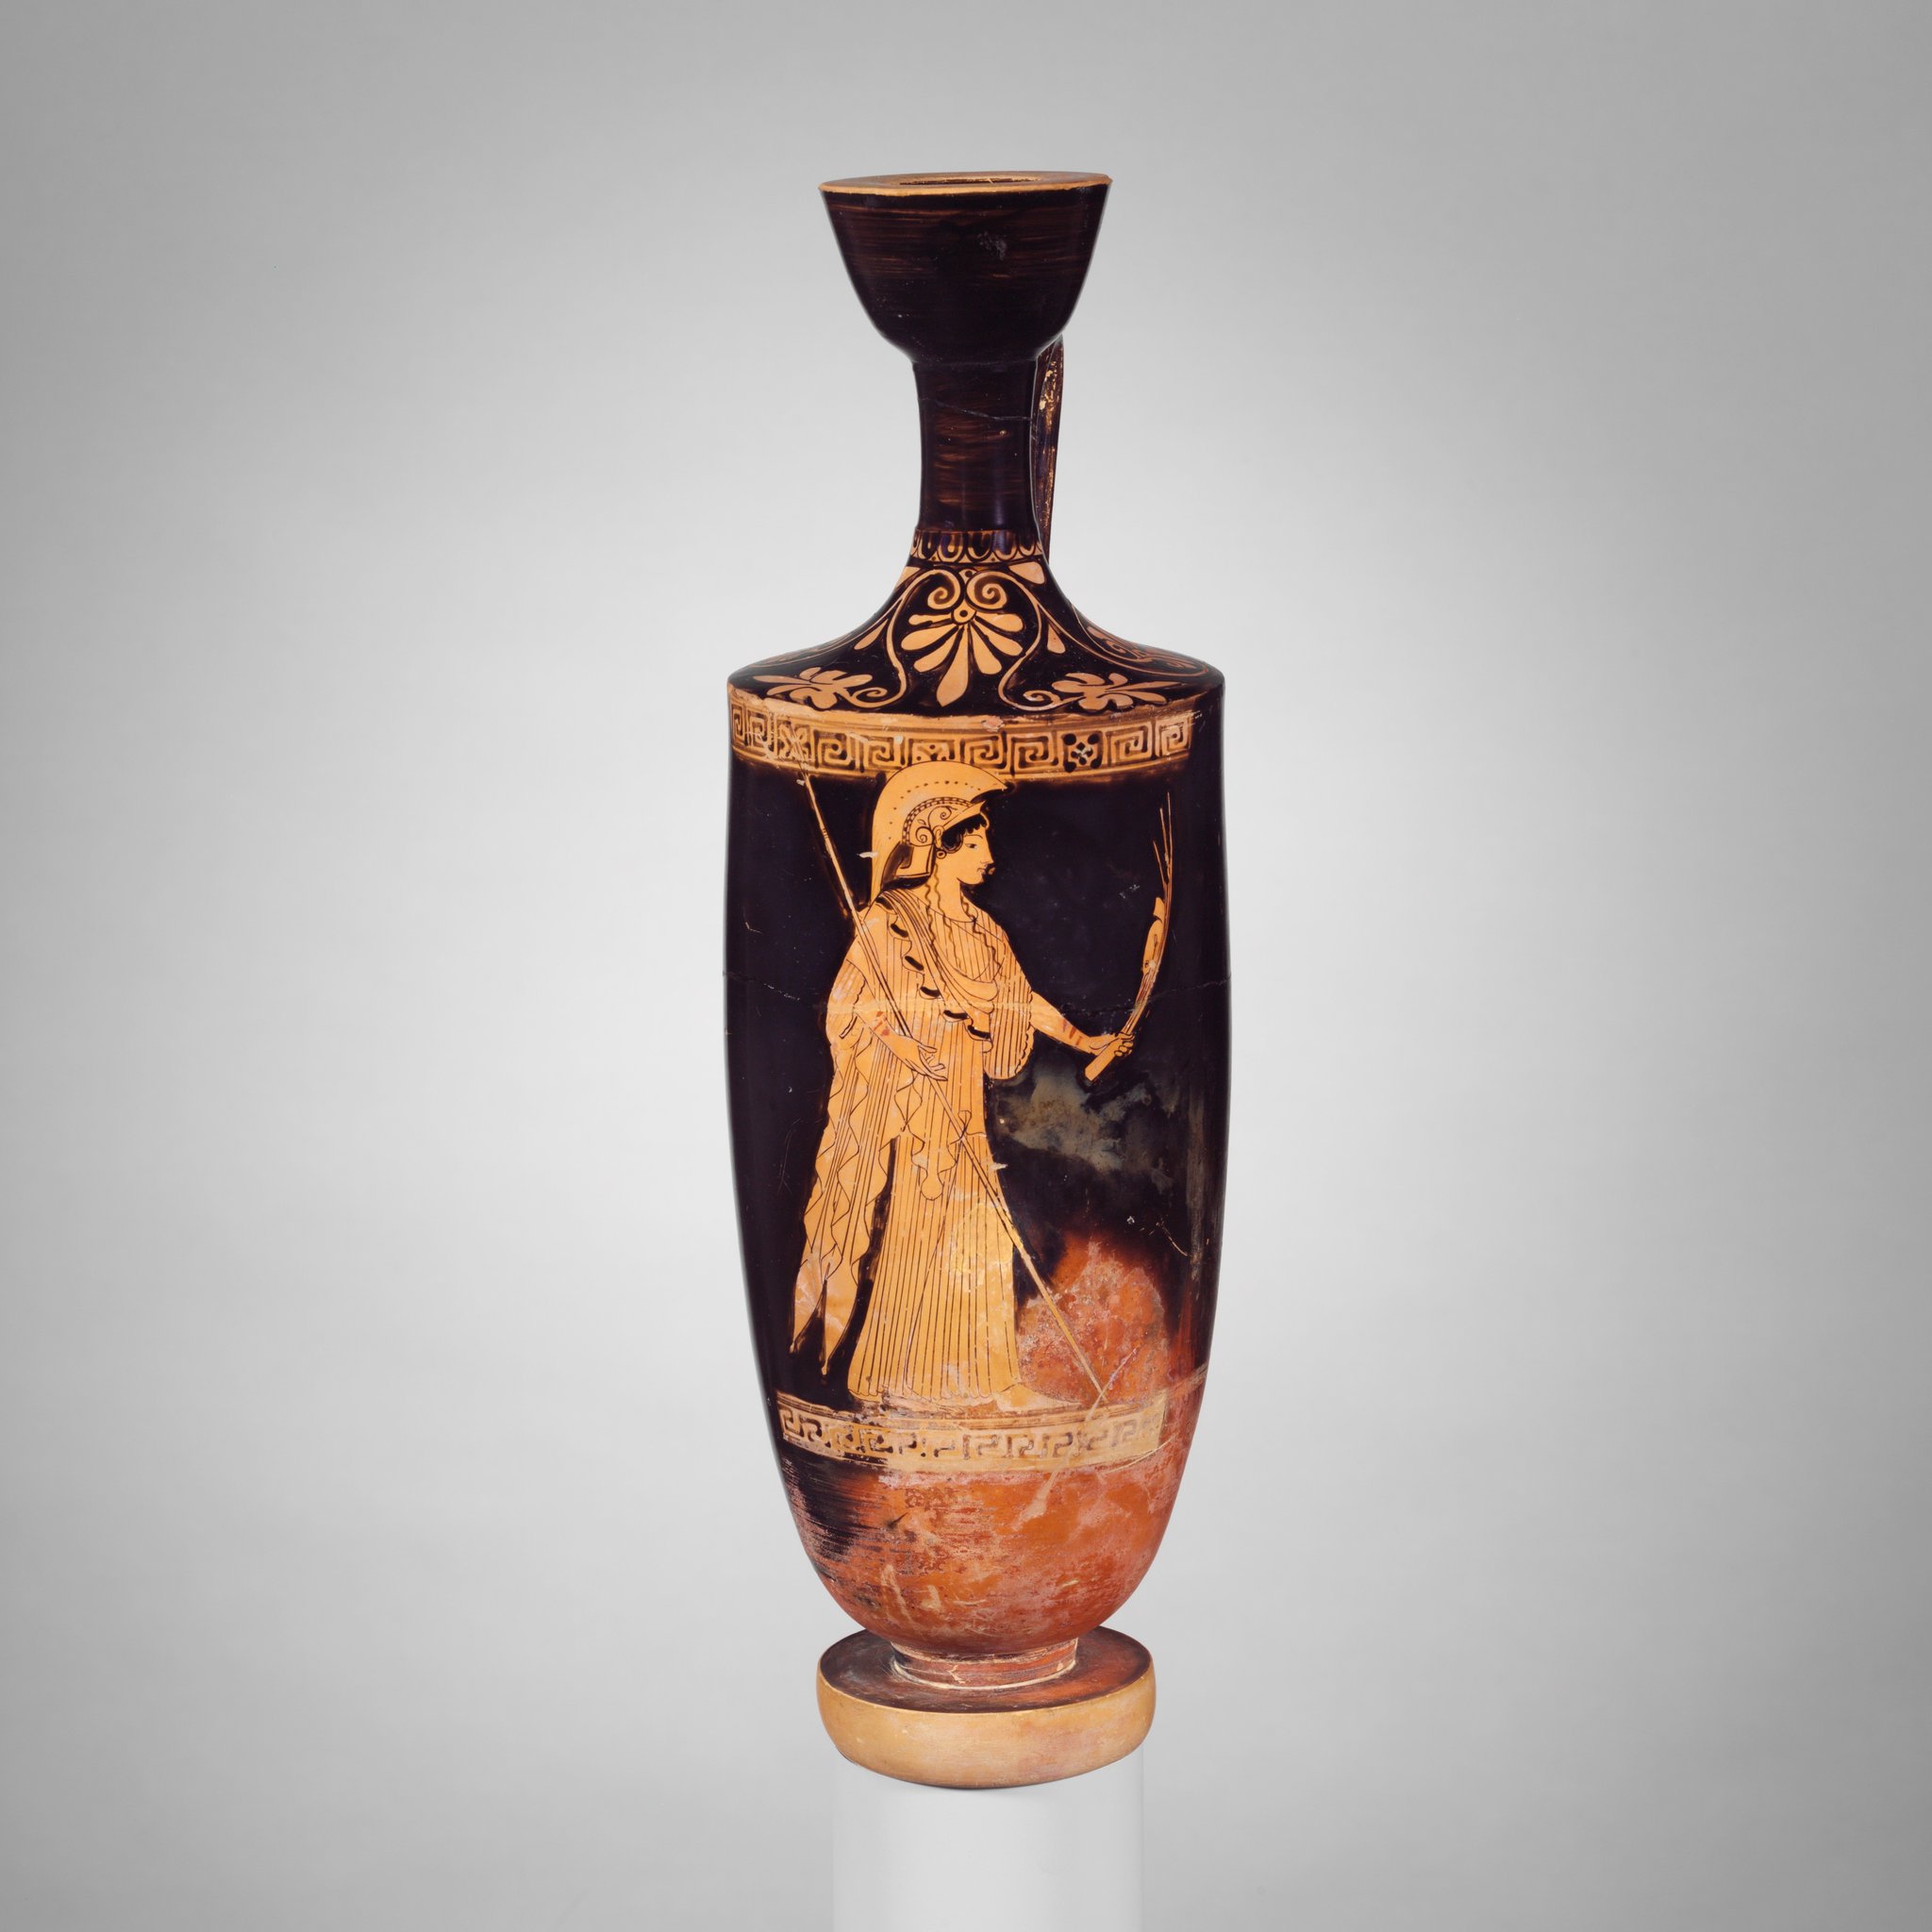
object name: lekythos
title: Terracotta lekythos (oil flask)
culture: greek, attic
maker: brygos painter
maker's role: artist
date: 480-470 BCE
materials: terracotta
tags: athena